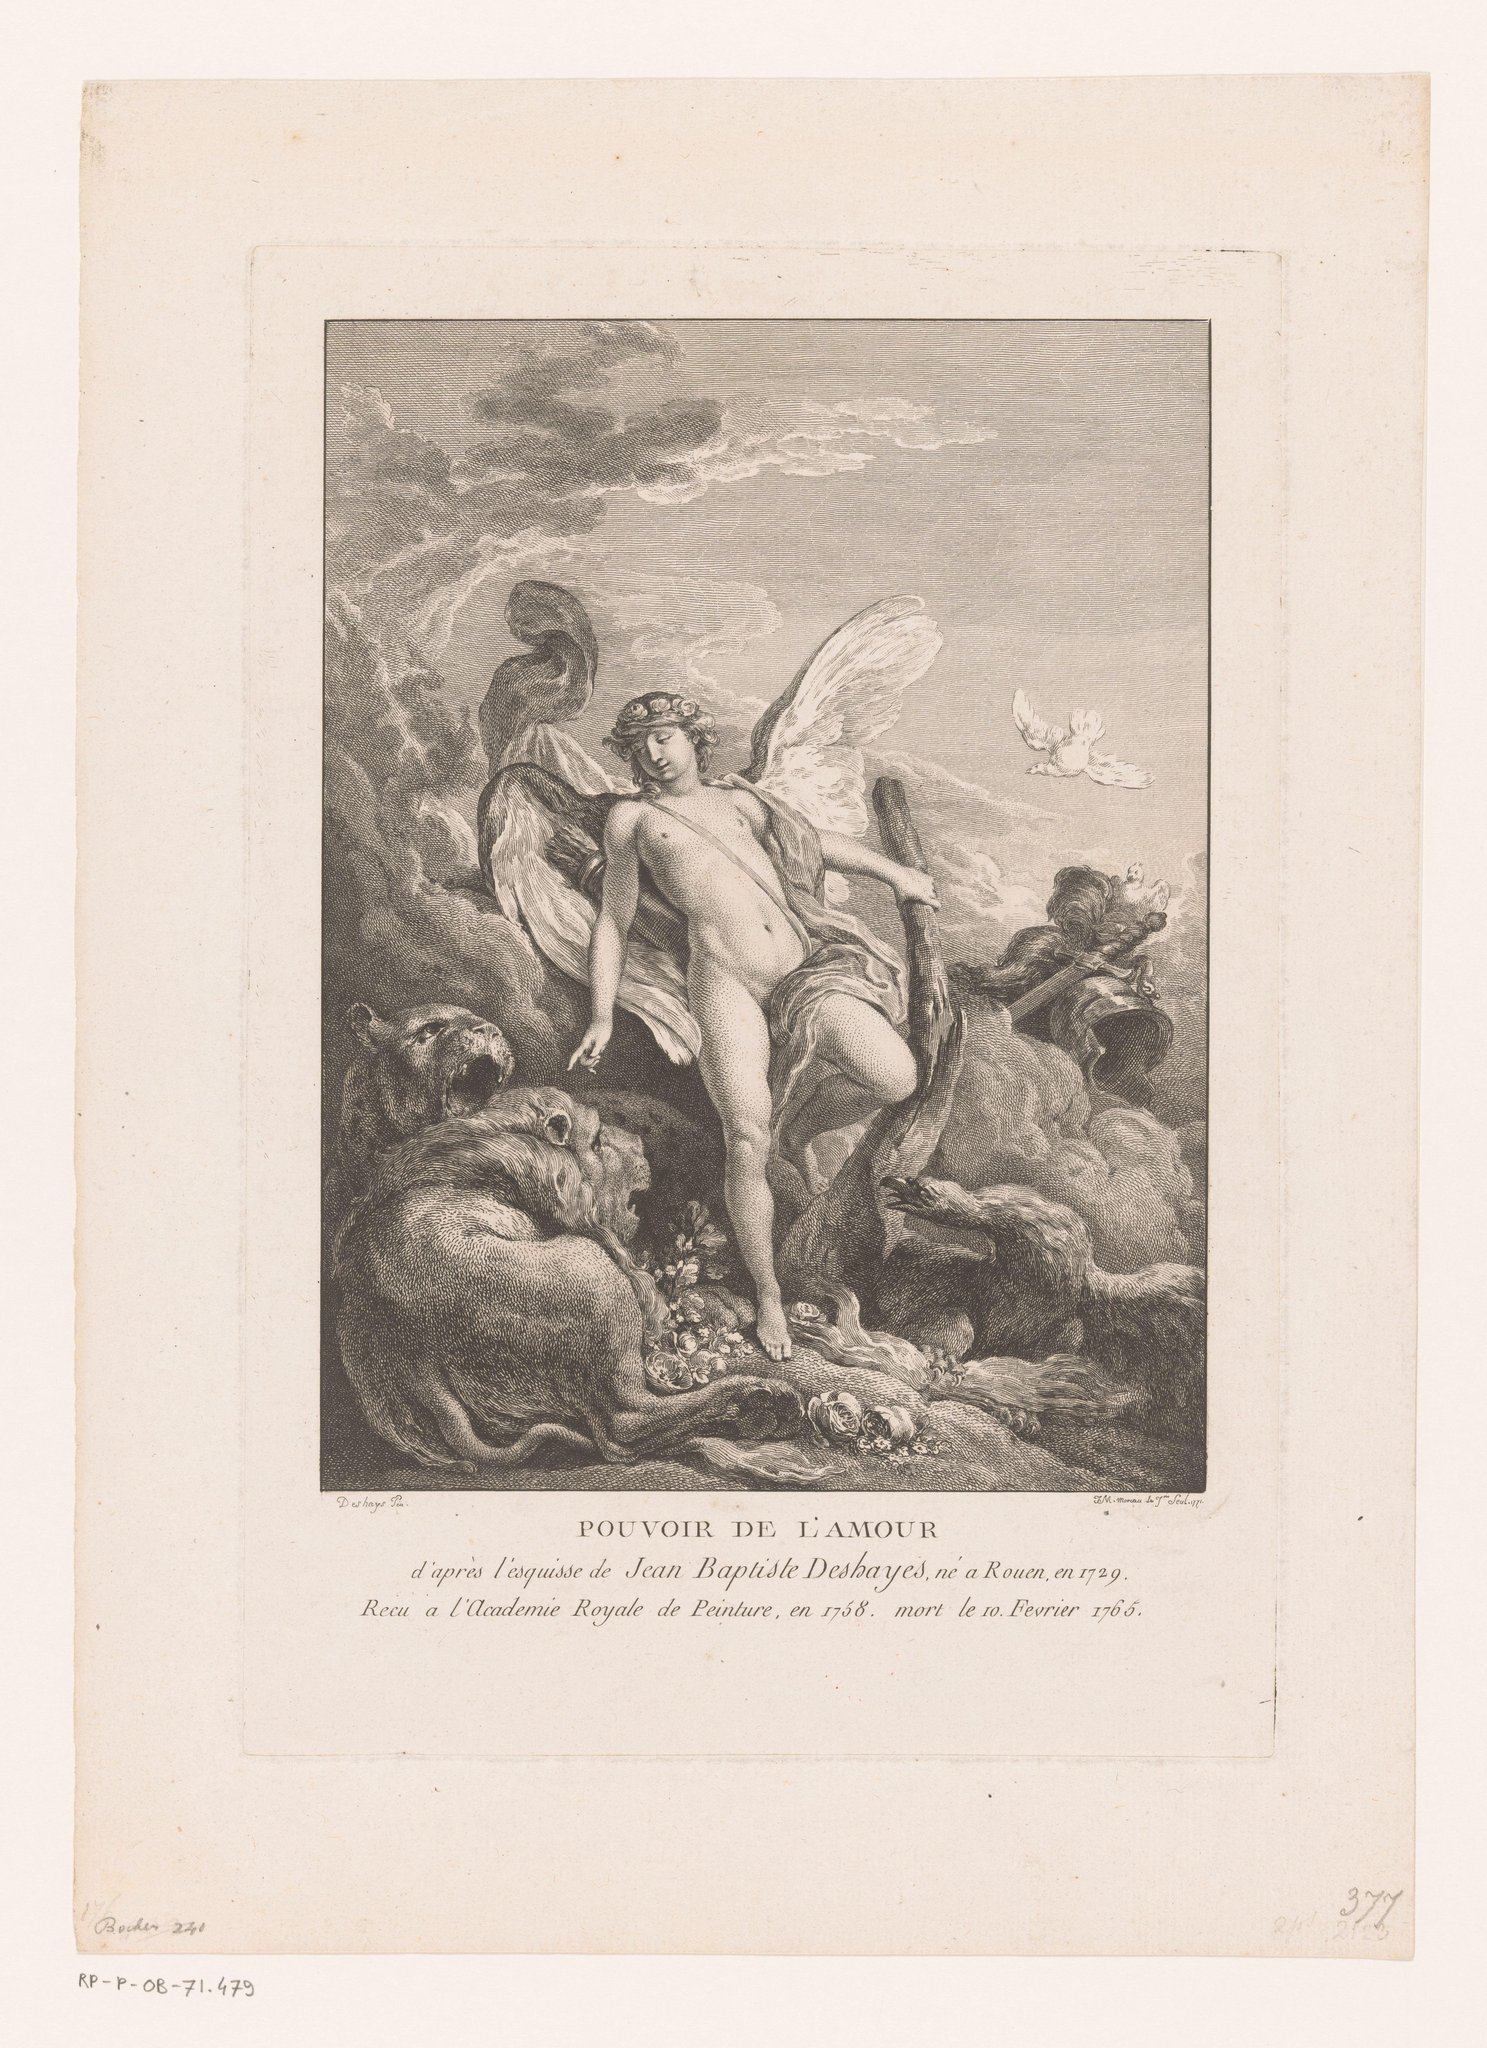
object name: print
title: Amor maant twee leeuwen tot rust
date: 1771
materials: paper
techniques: etching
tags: cupid disarming the strong; the power of love, beasts of prey, predatory animals: lion, attributes of jupiter: eagle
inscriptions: collector's mark: Lugt 240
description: Amor wijst met zijn rechterhand naar twee leeuwen aan zijn voeten. Rechts Jupiter in de vorm van een adelaar.